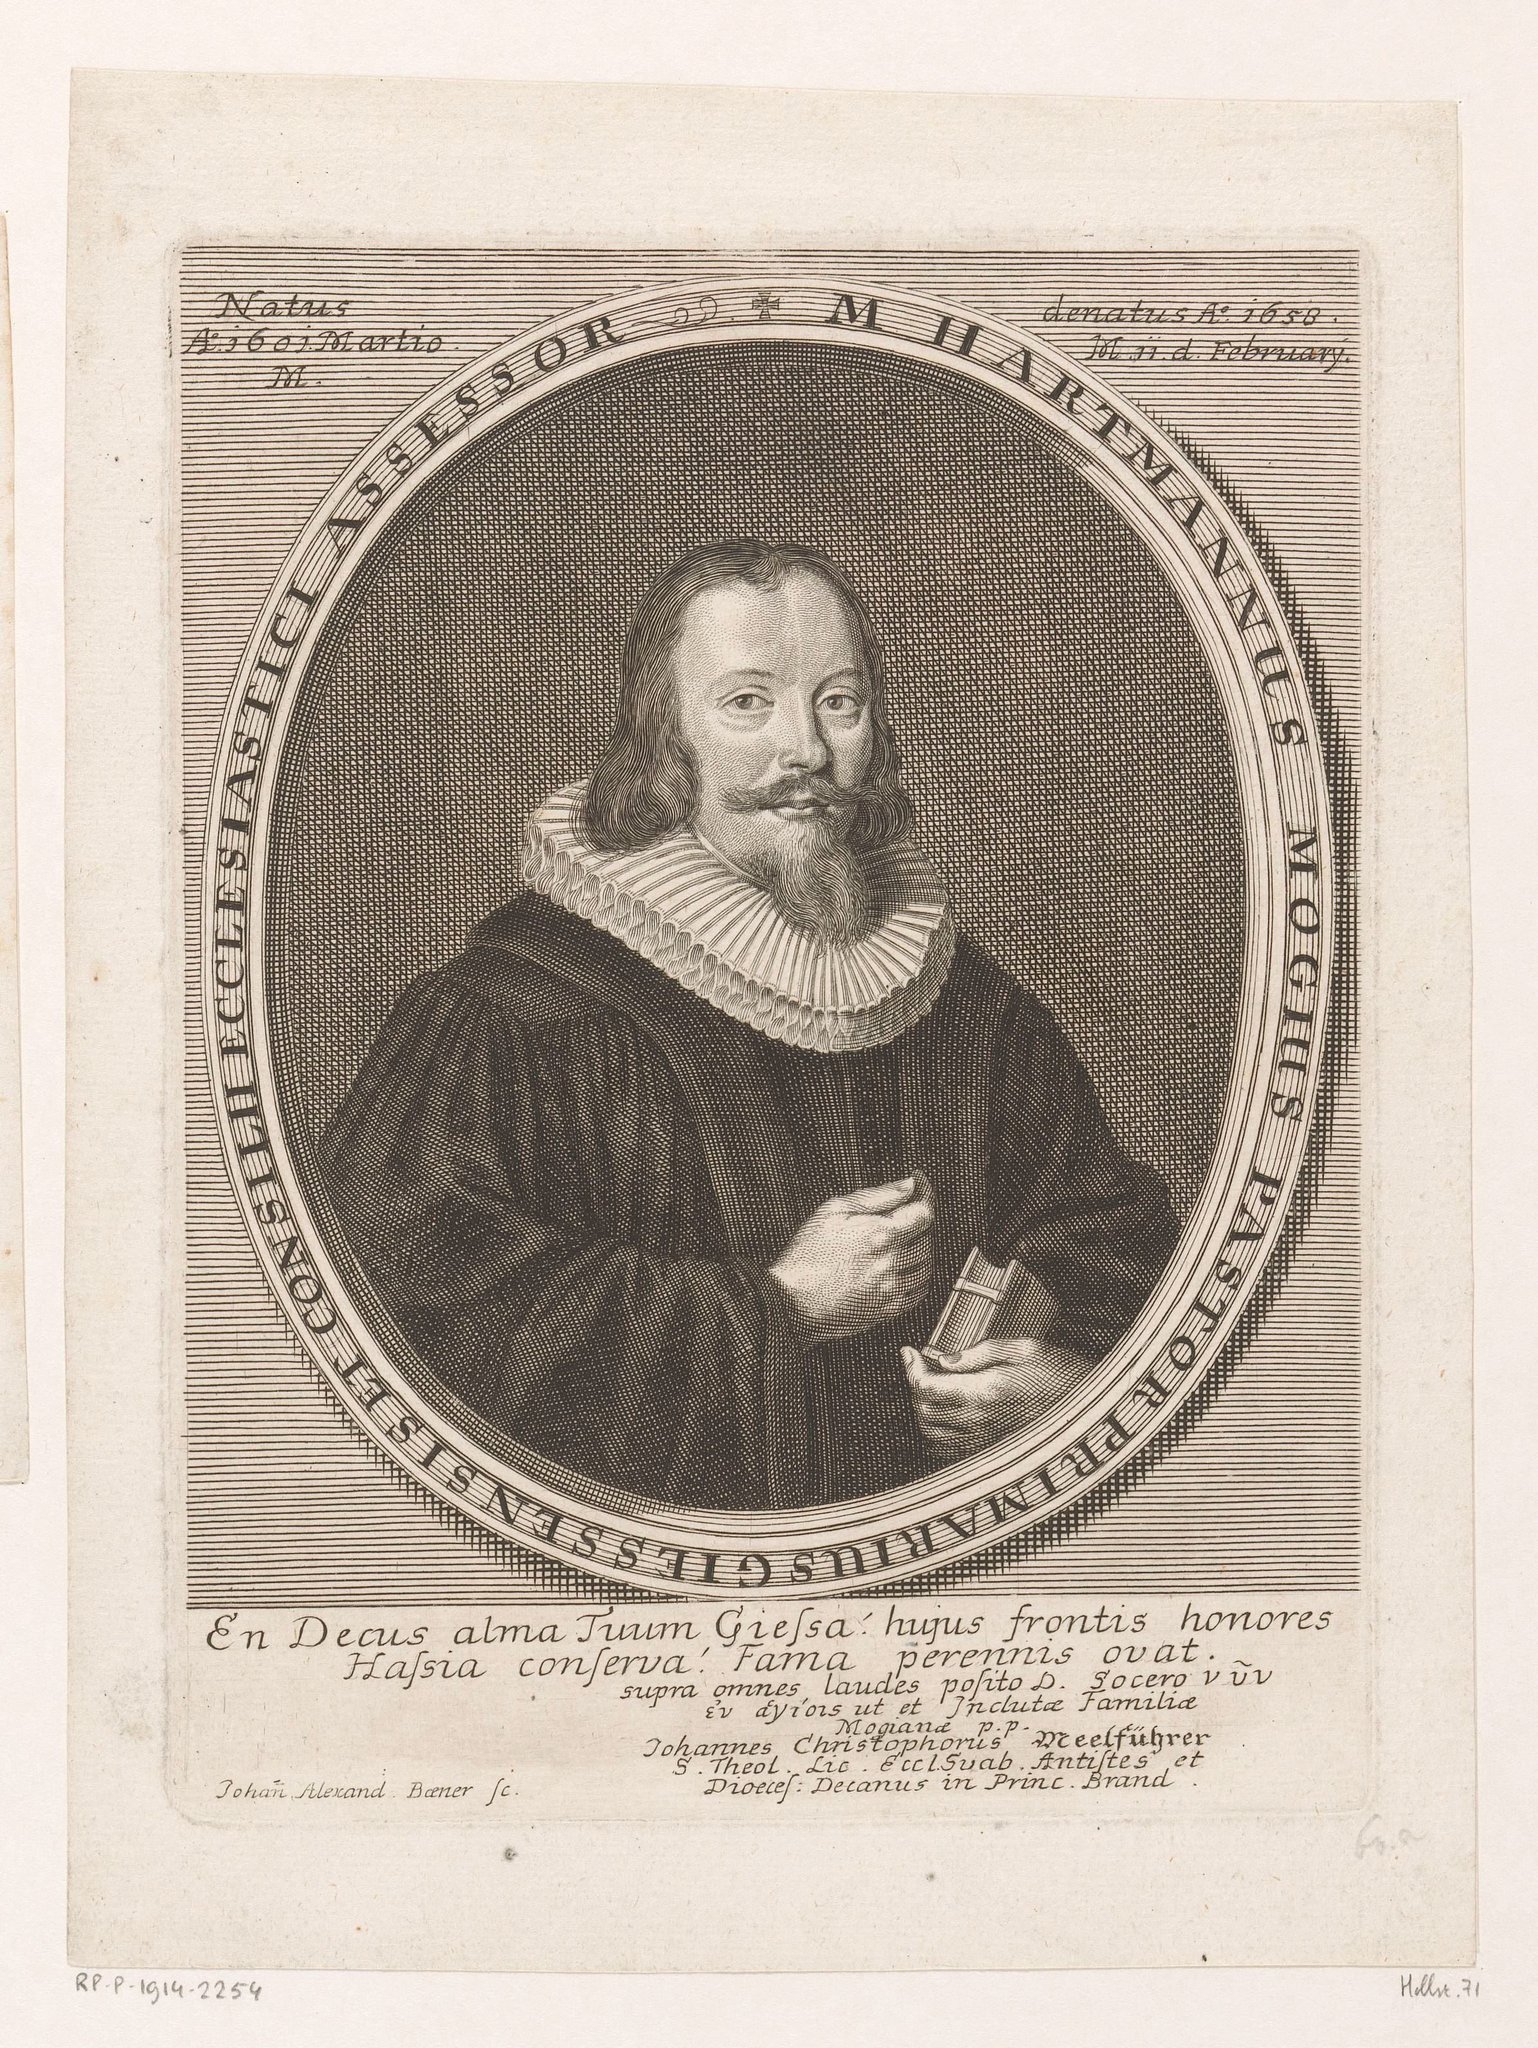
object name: print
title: Portret van Hartmann Mogen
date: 1658-1720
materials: paper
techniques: engraving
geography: nuremberg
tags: historical persons, book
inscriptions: collector's mark: Lugt 2228